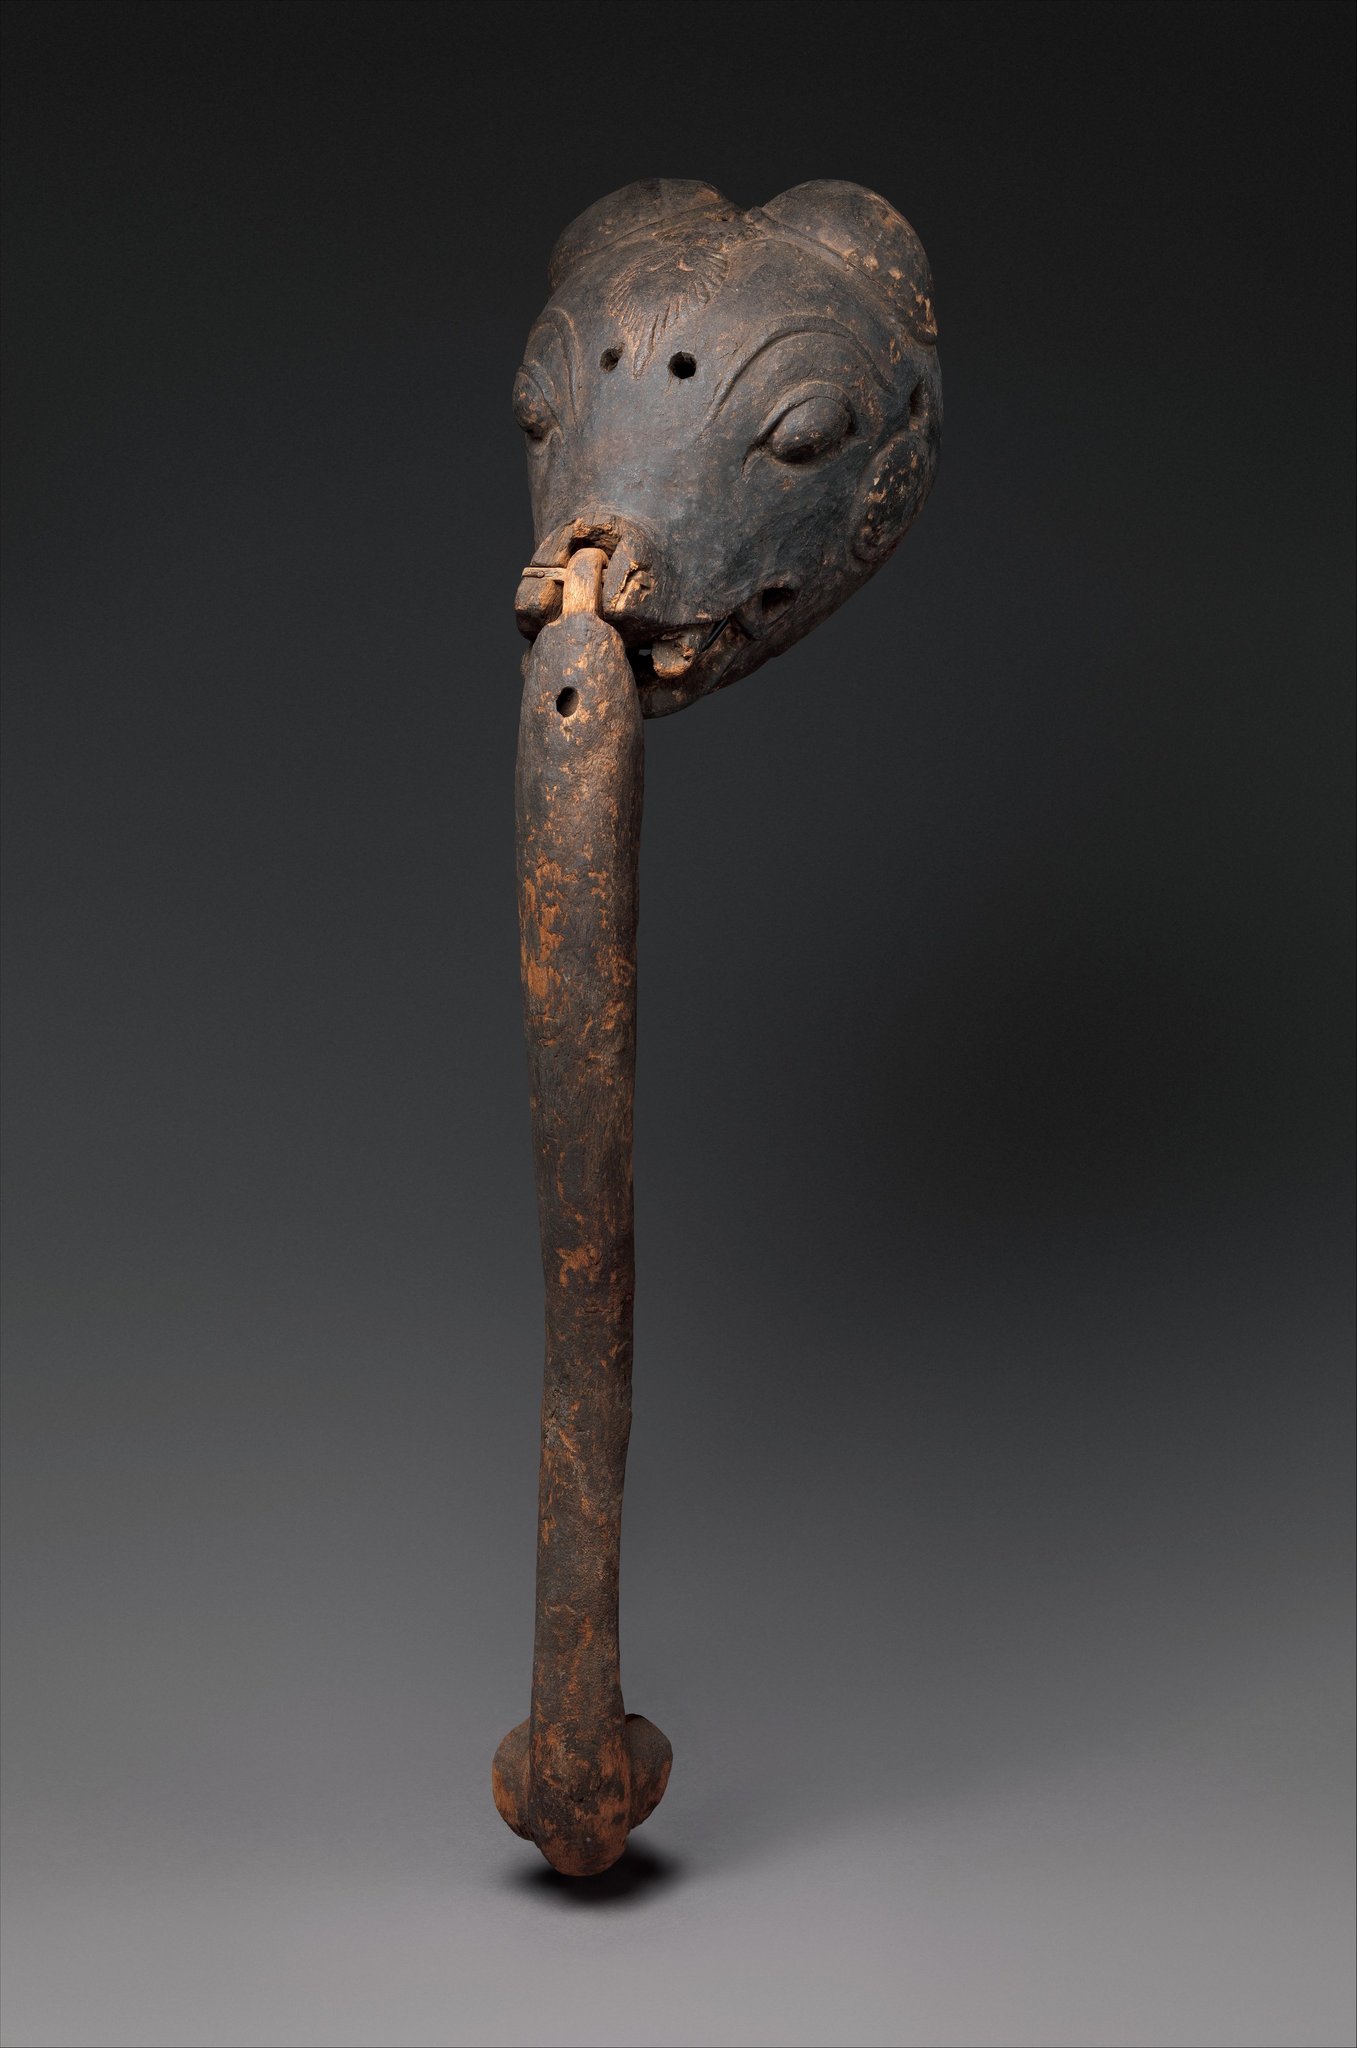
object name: mask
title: Ganesha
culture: indian, southern, tamil nadu, thanjavur district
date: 1700-1750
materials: textile, wood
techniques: polychrome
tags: ganesha